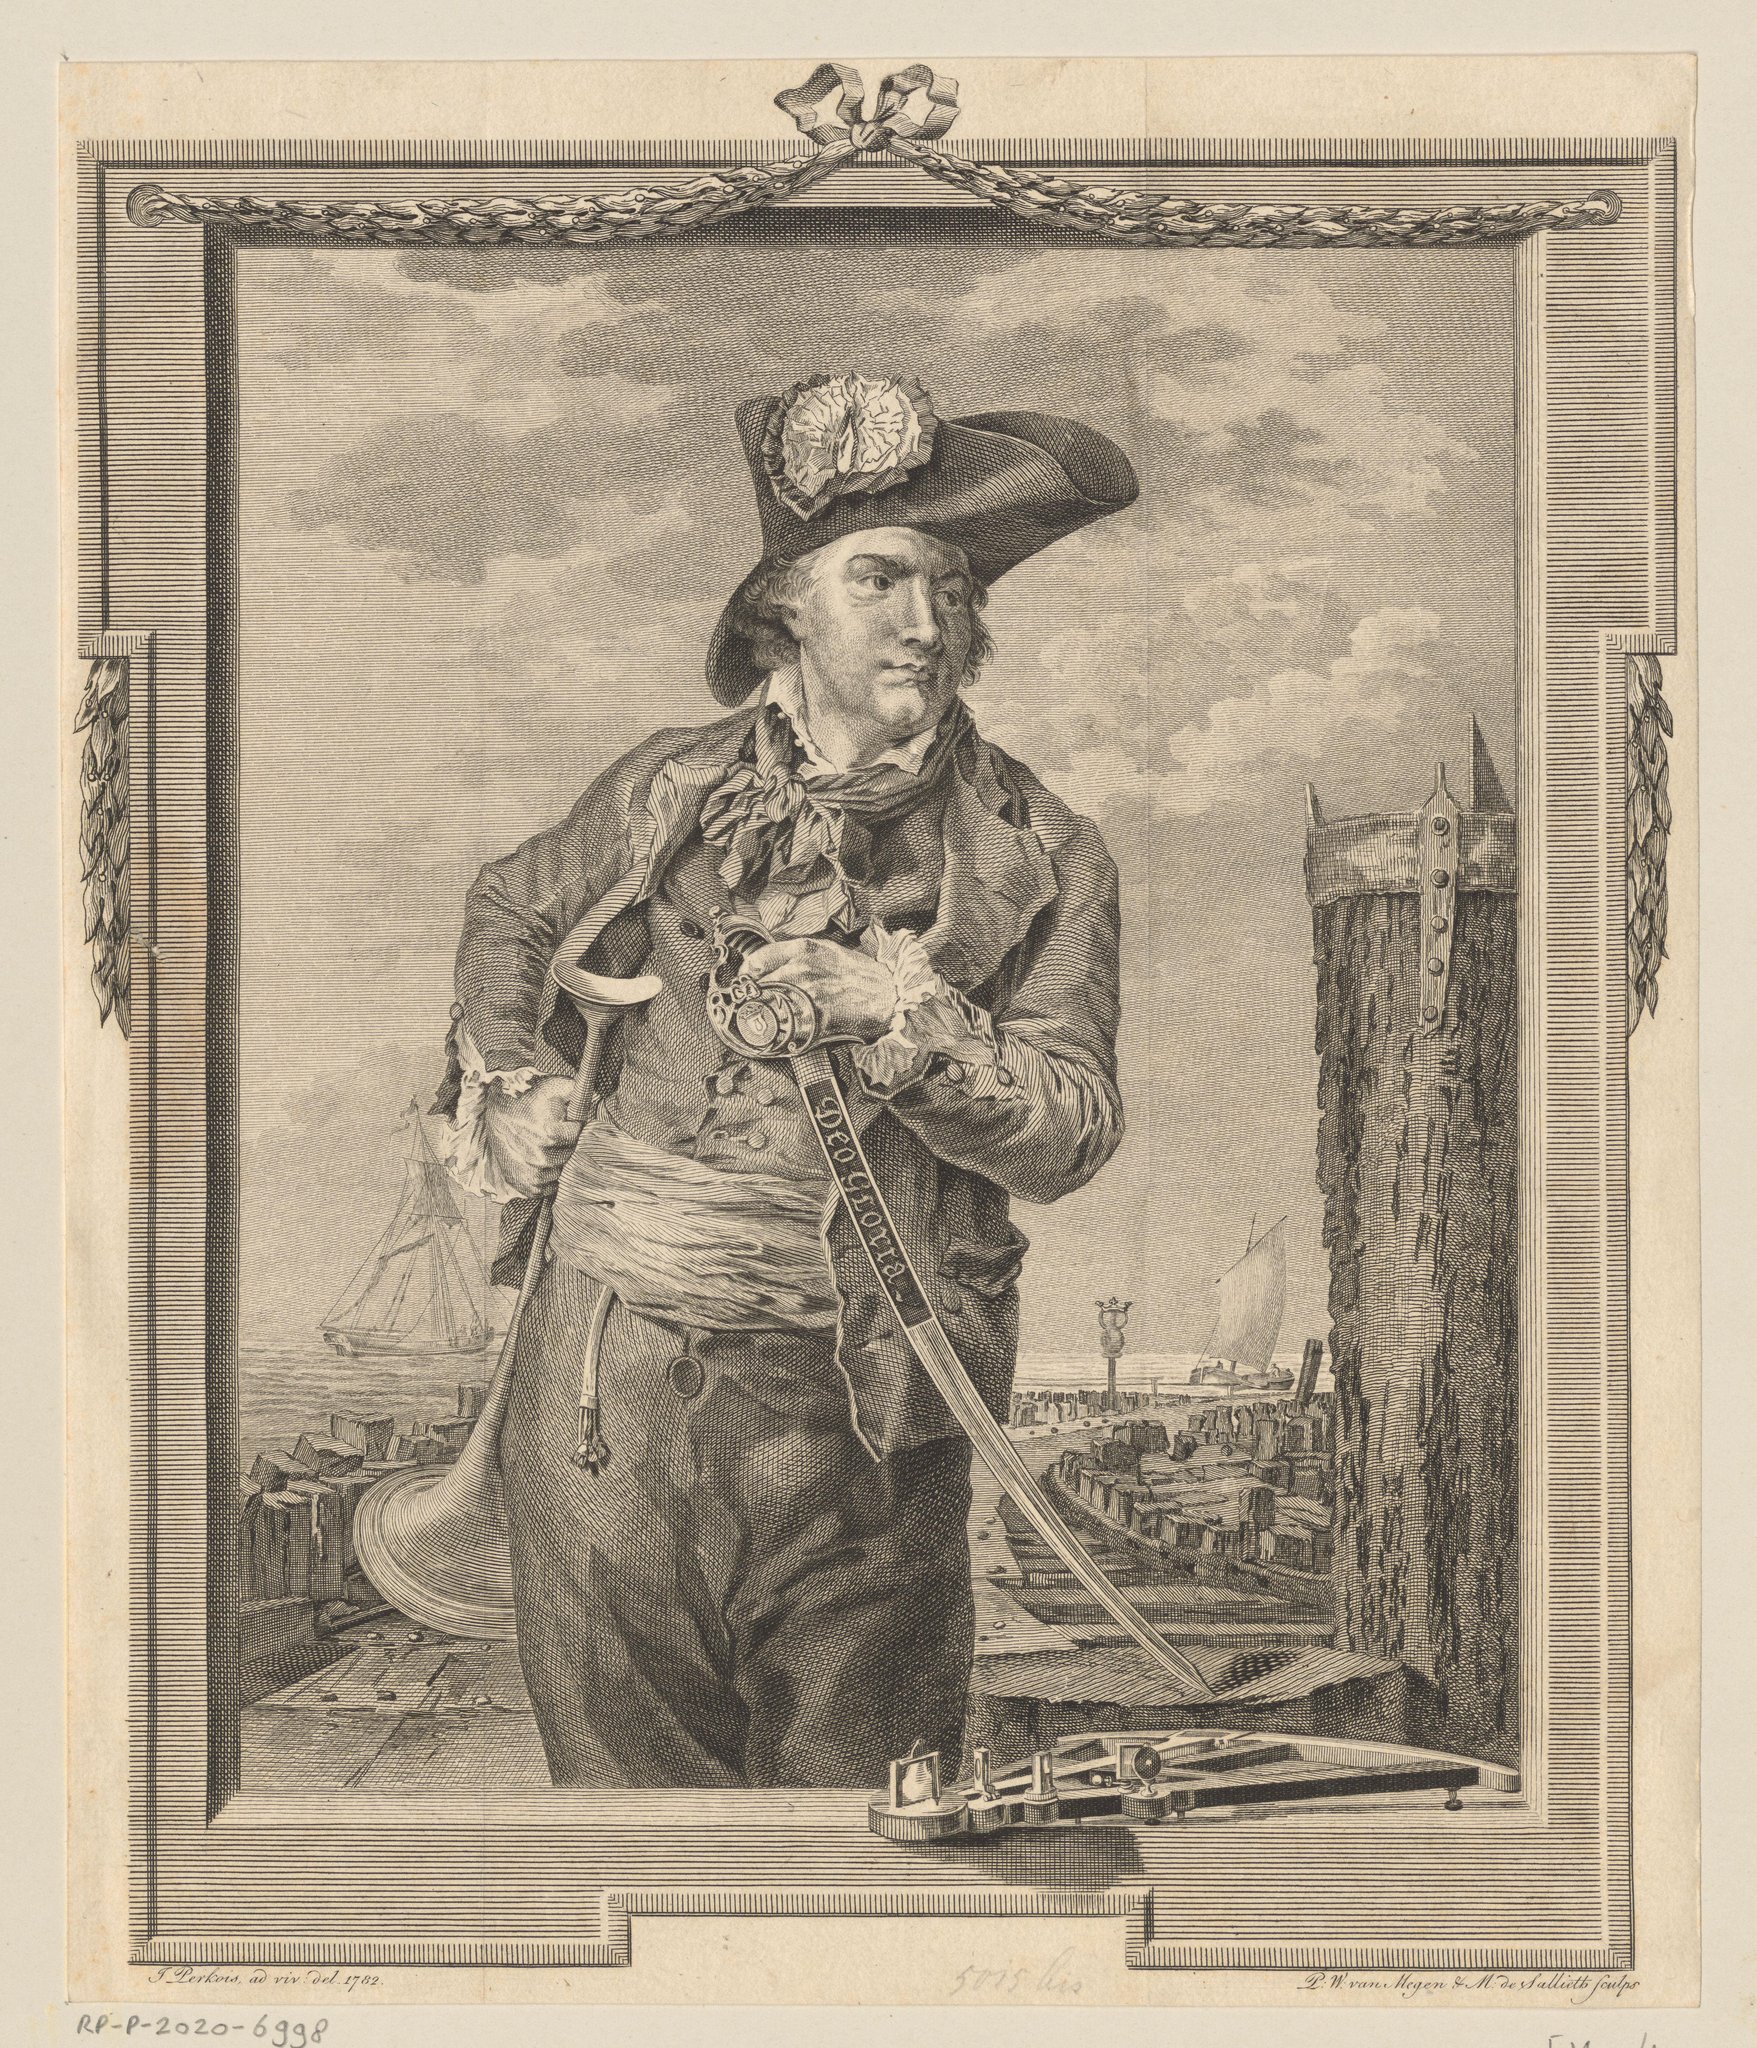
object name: print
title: Portret van Nicolas Jarry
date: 1782-1785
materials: paper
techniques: engraving, etching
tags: capuche, head-gear, horn, trumpet, cornet, trombone, tuba, historical persons, hacking and thrusting weapons: sword, seaman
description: Staand in een kustlandschap met in zijn linkerhand een sabel en in zijn rechterhand een blaasinstrument. Achter hem varen twee schepen op zee.